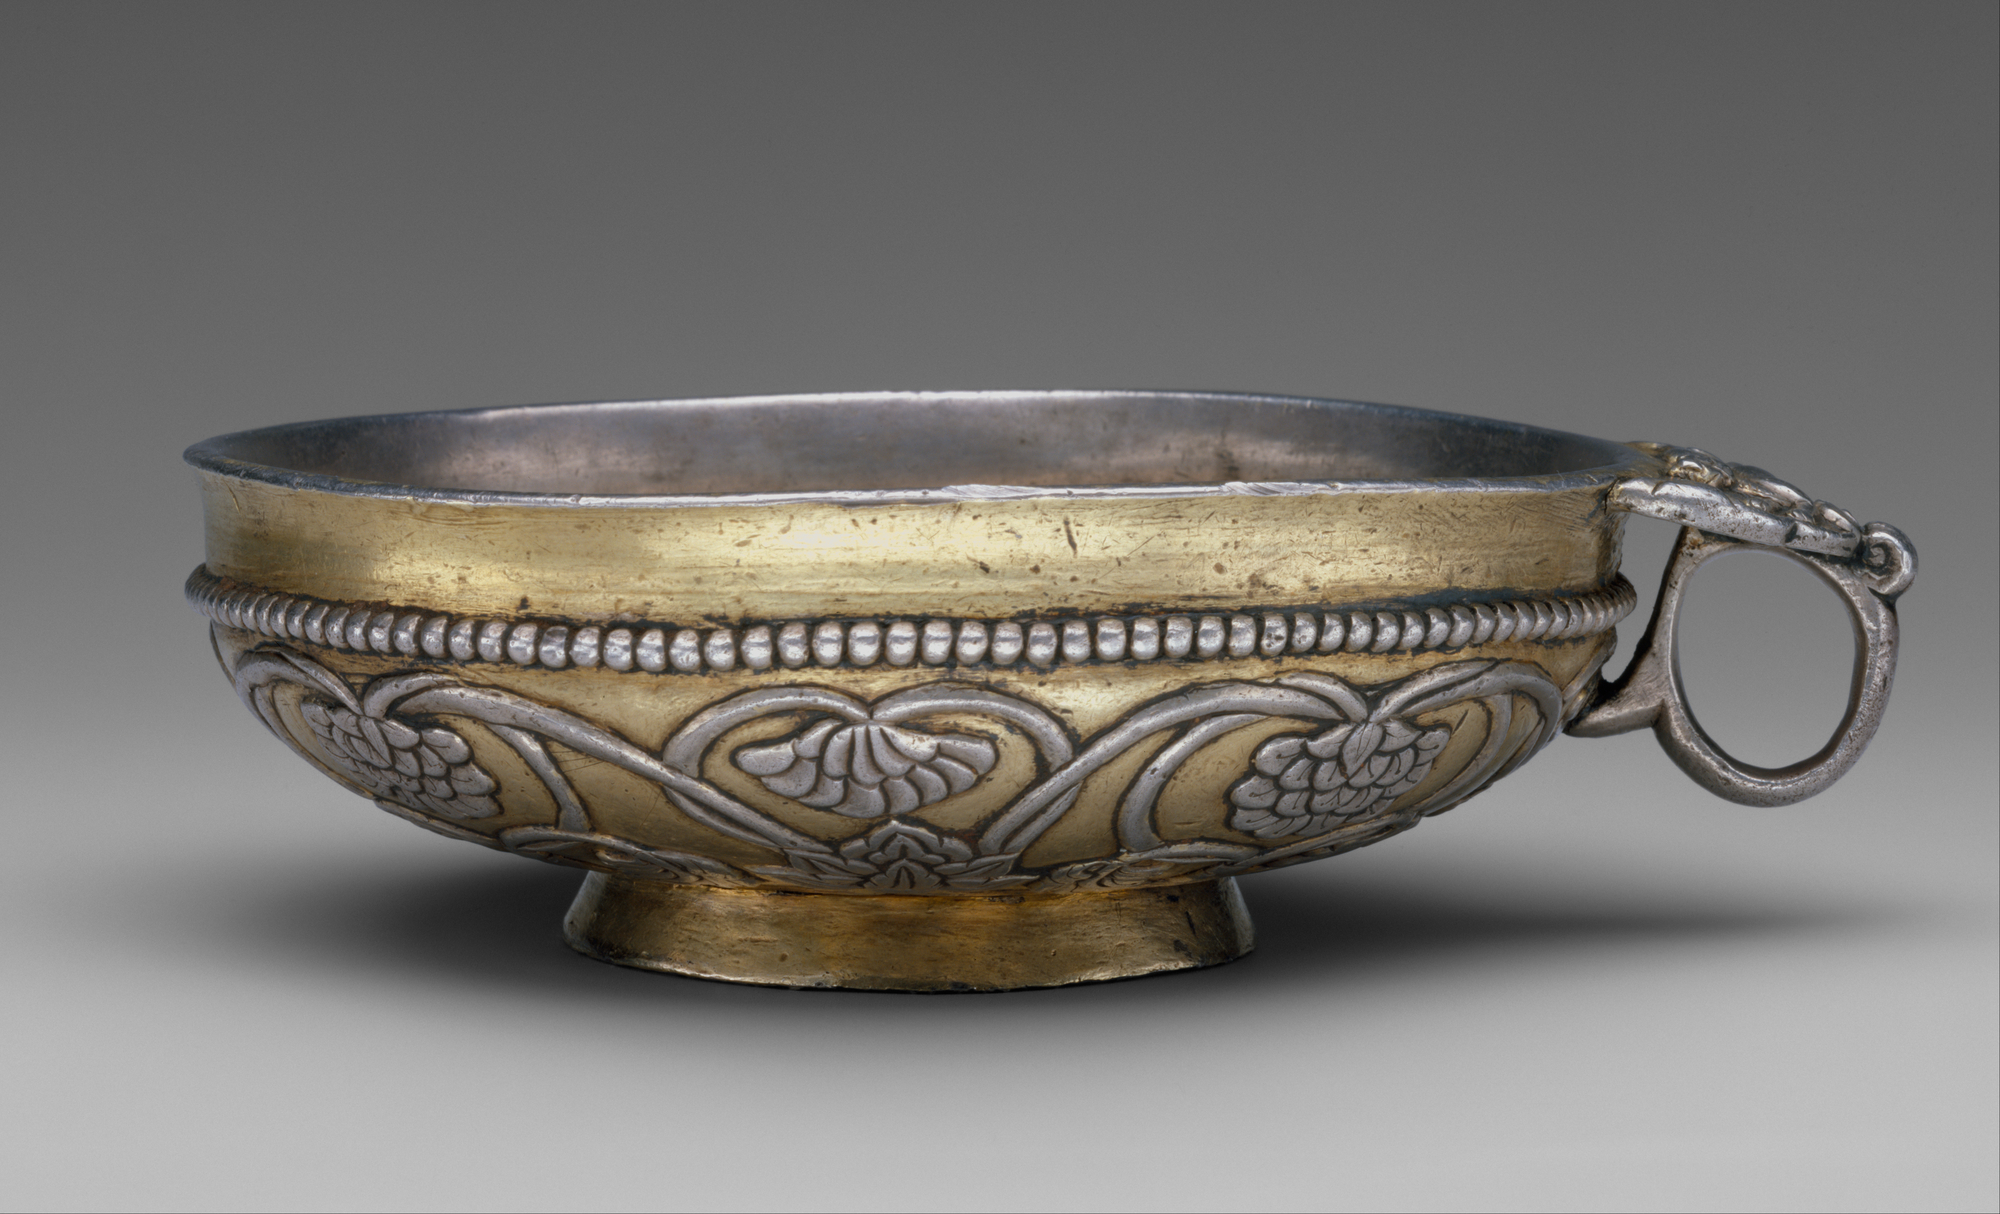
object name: cup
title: Large Cup with Ring Handle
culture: chinese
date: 701-800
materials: silver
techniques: gilding